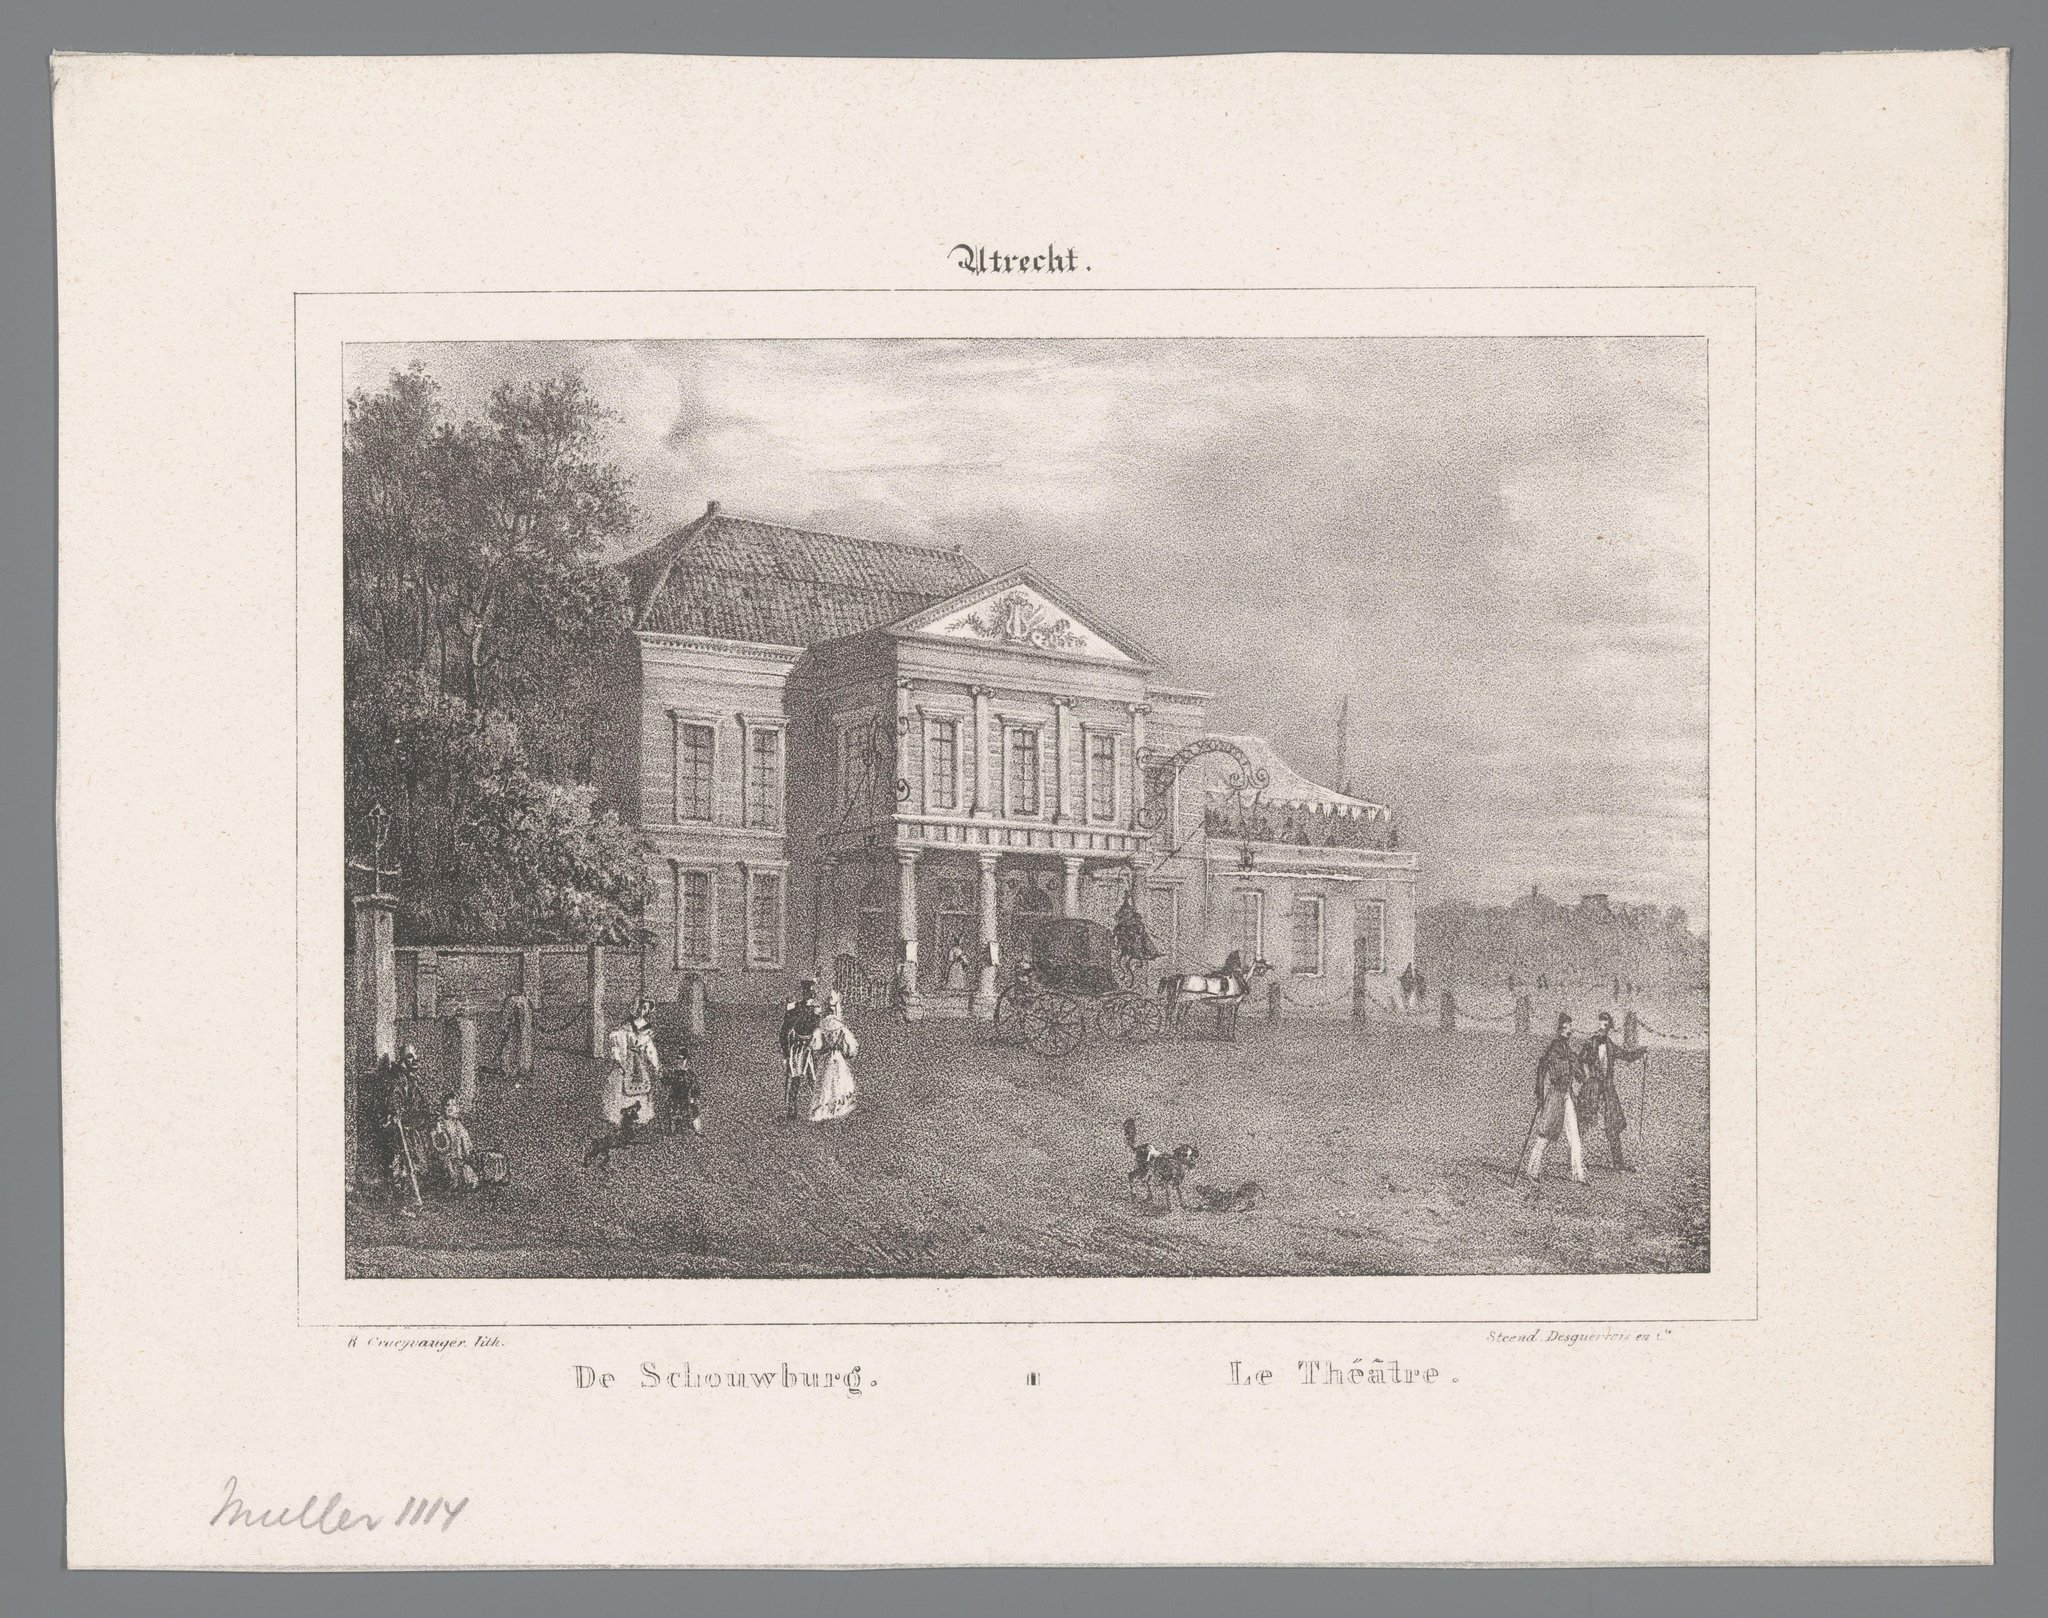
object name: print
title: Utrecht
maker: reinier craeyvanger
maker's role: draughtsman, print maker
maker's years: 1812-1880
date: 1827-1900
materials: paper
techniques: lithograph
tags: city-view, and landscape with man-made constructions, theatre, theatrical performance, utrecht